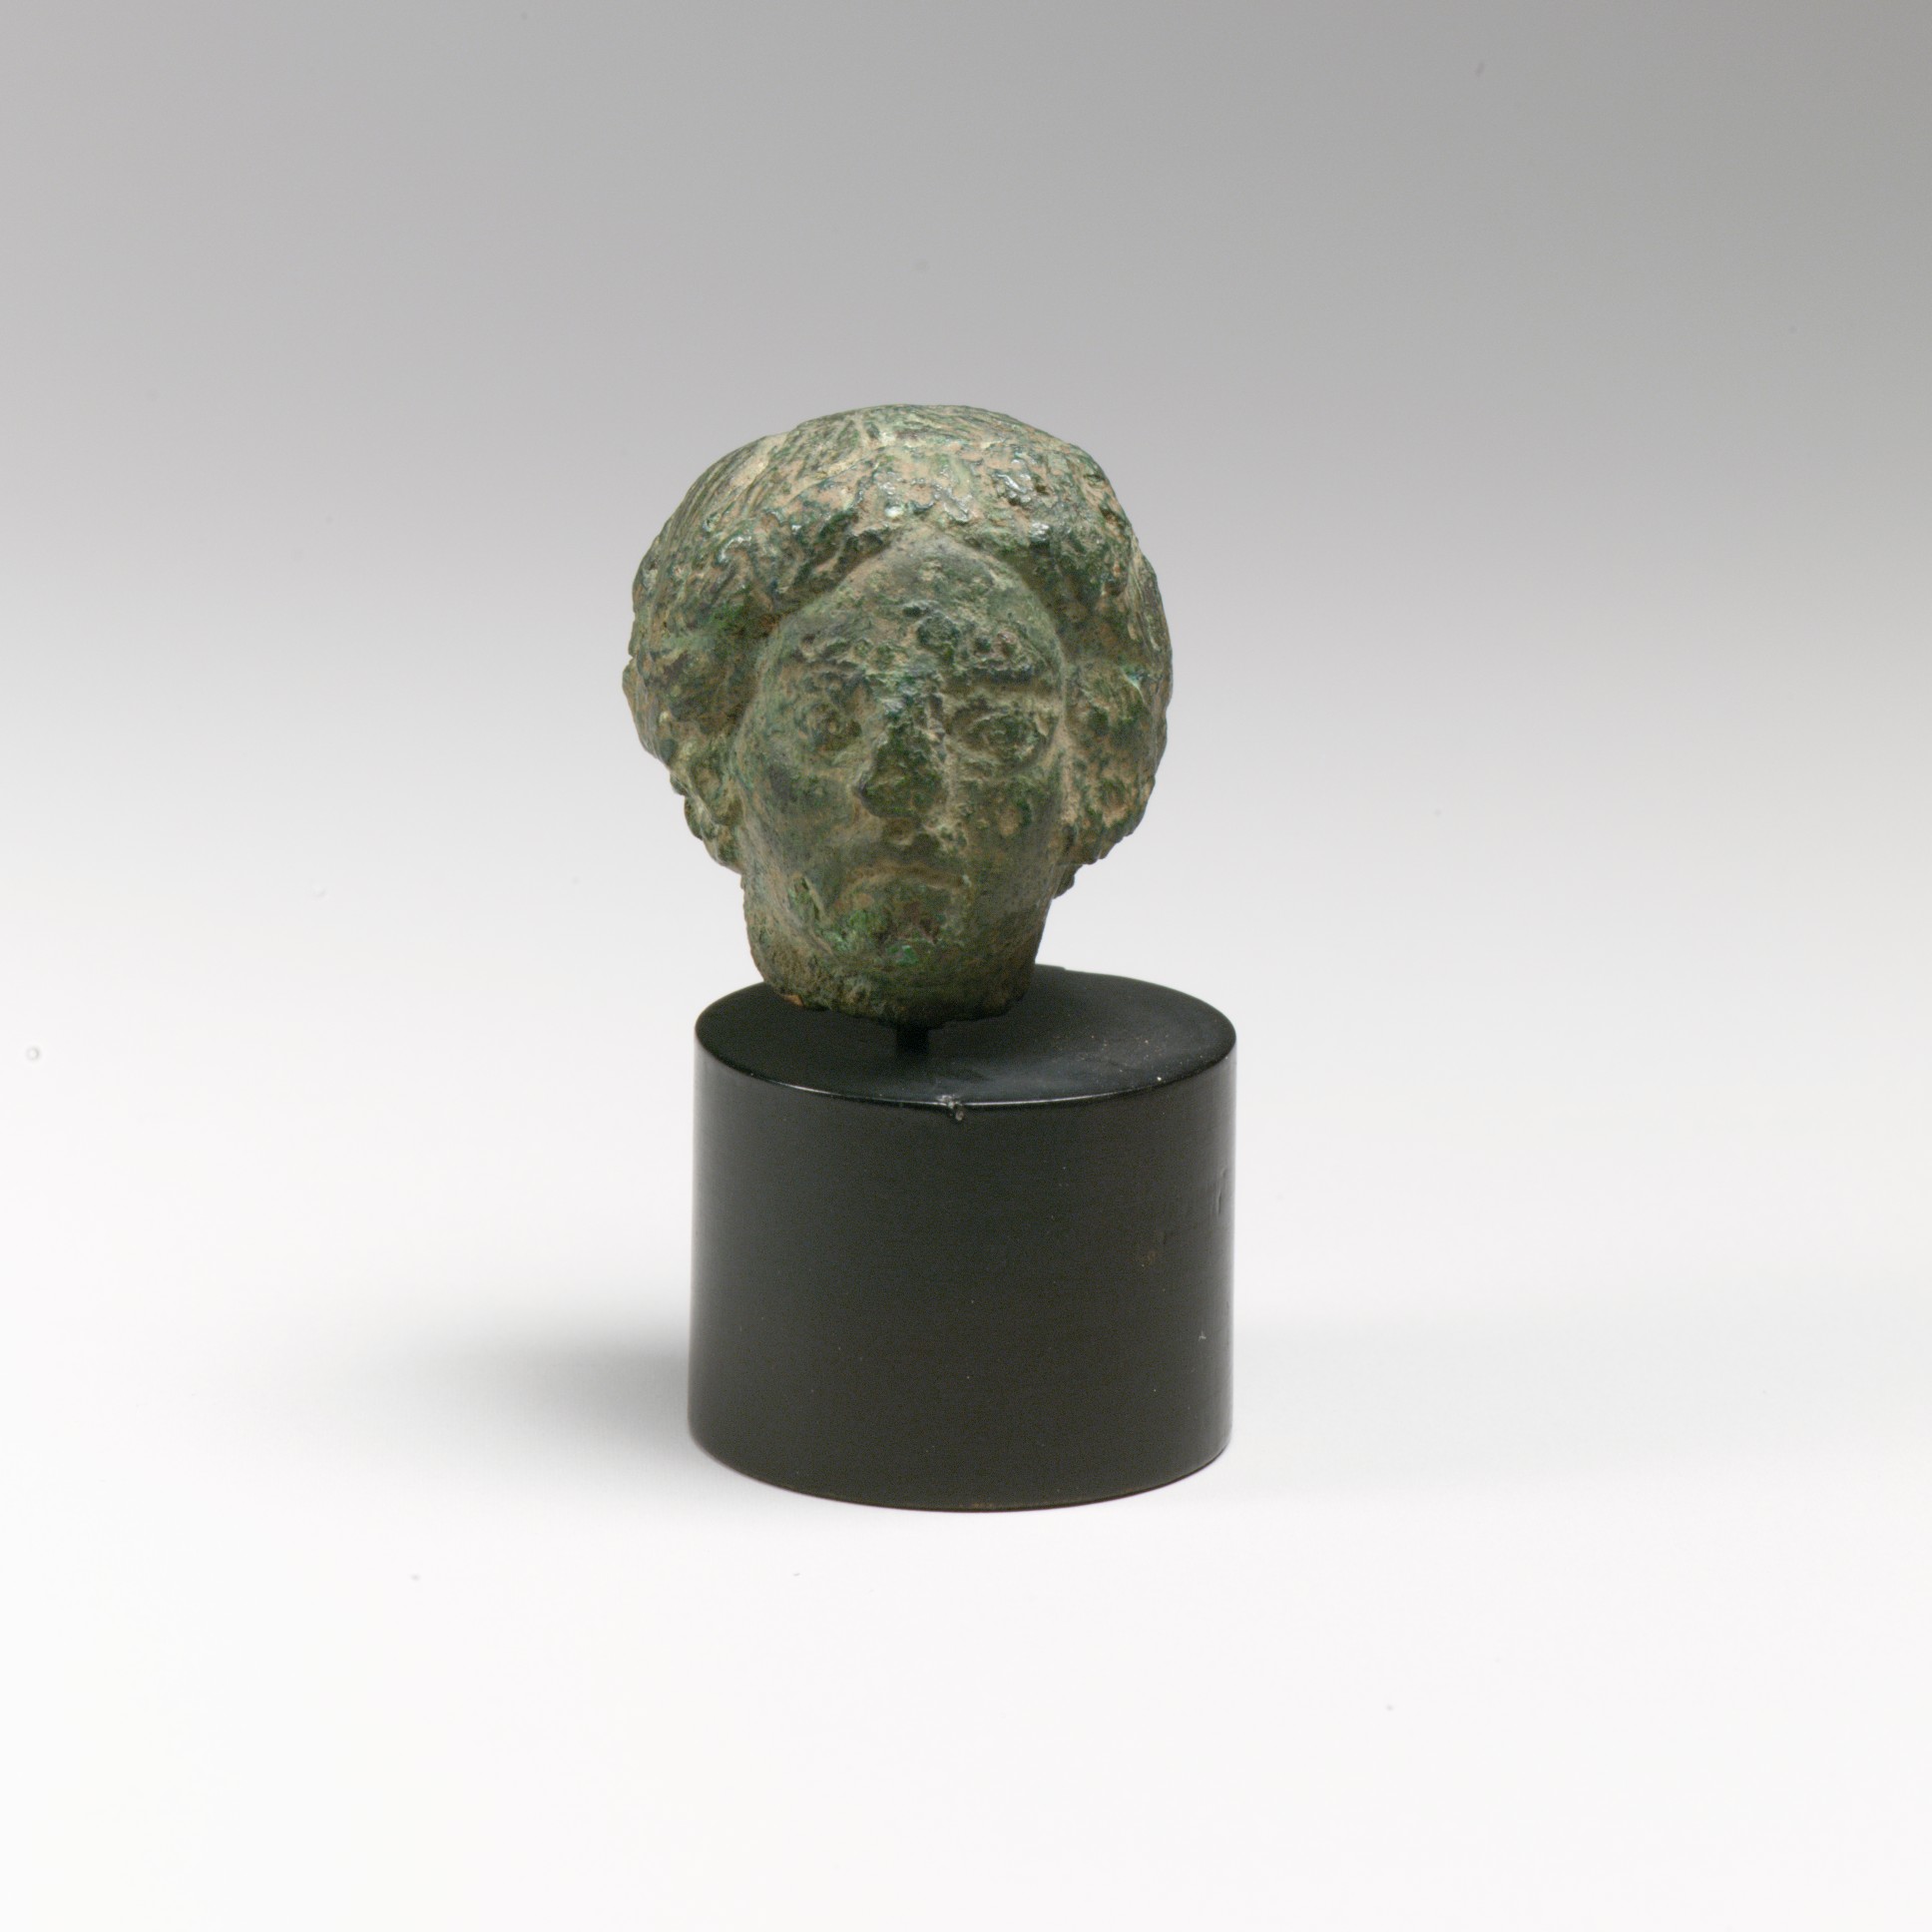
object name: head of a youth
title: Bronze head of a youth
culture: etruscan or roman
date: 200 BCE-200 CE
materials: bronze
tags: heads